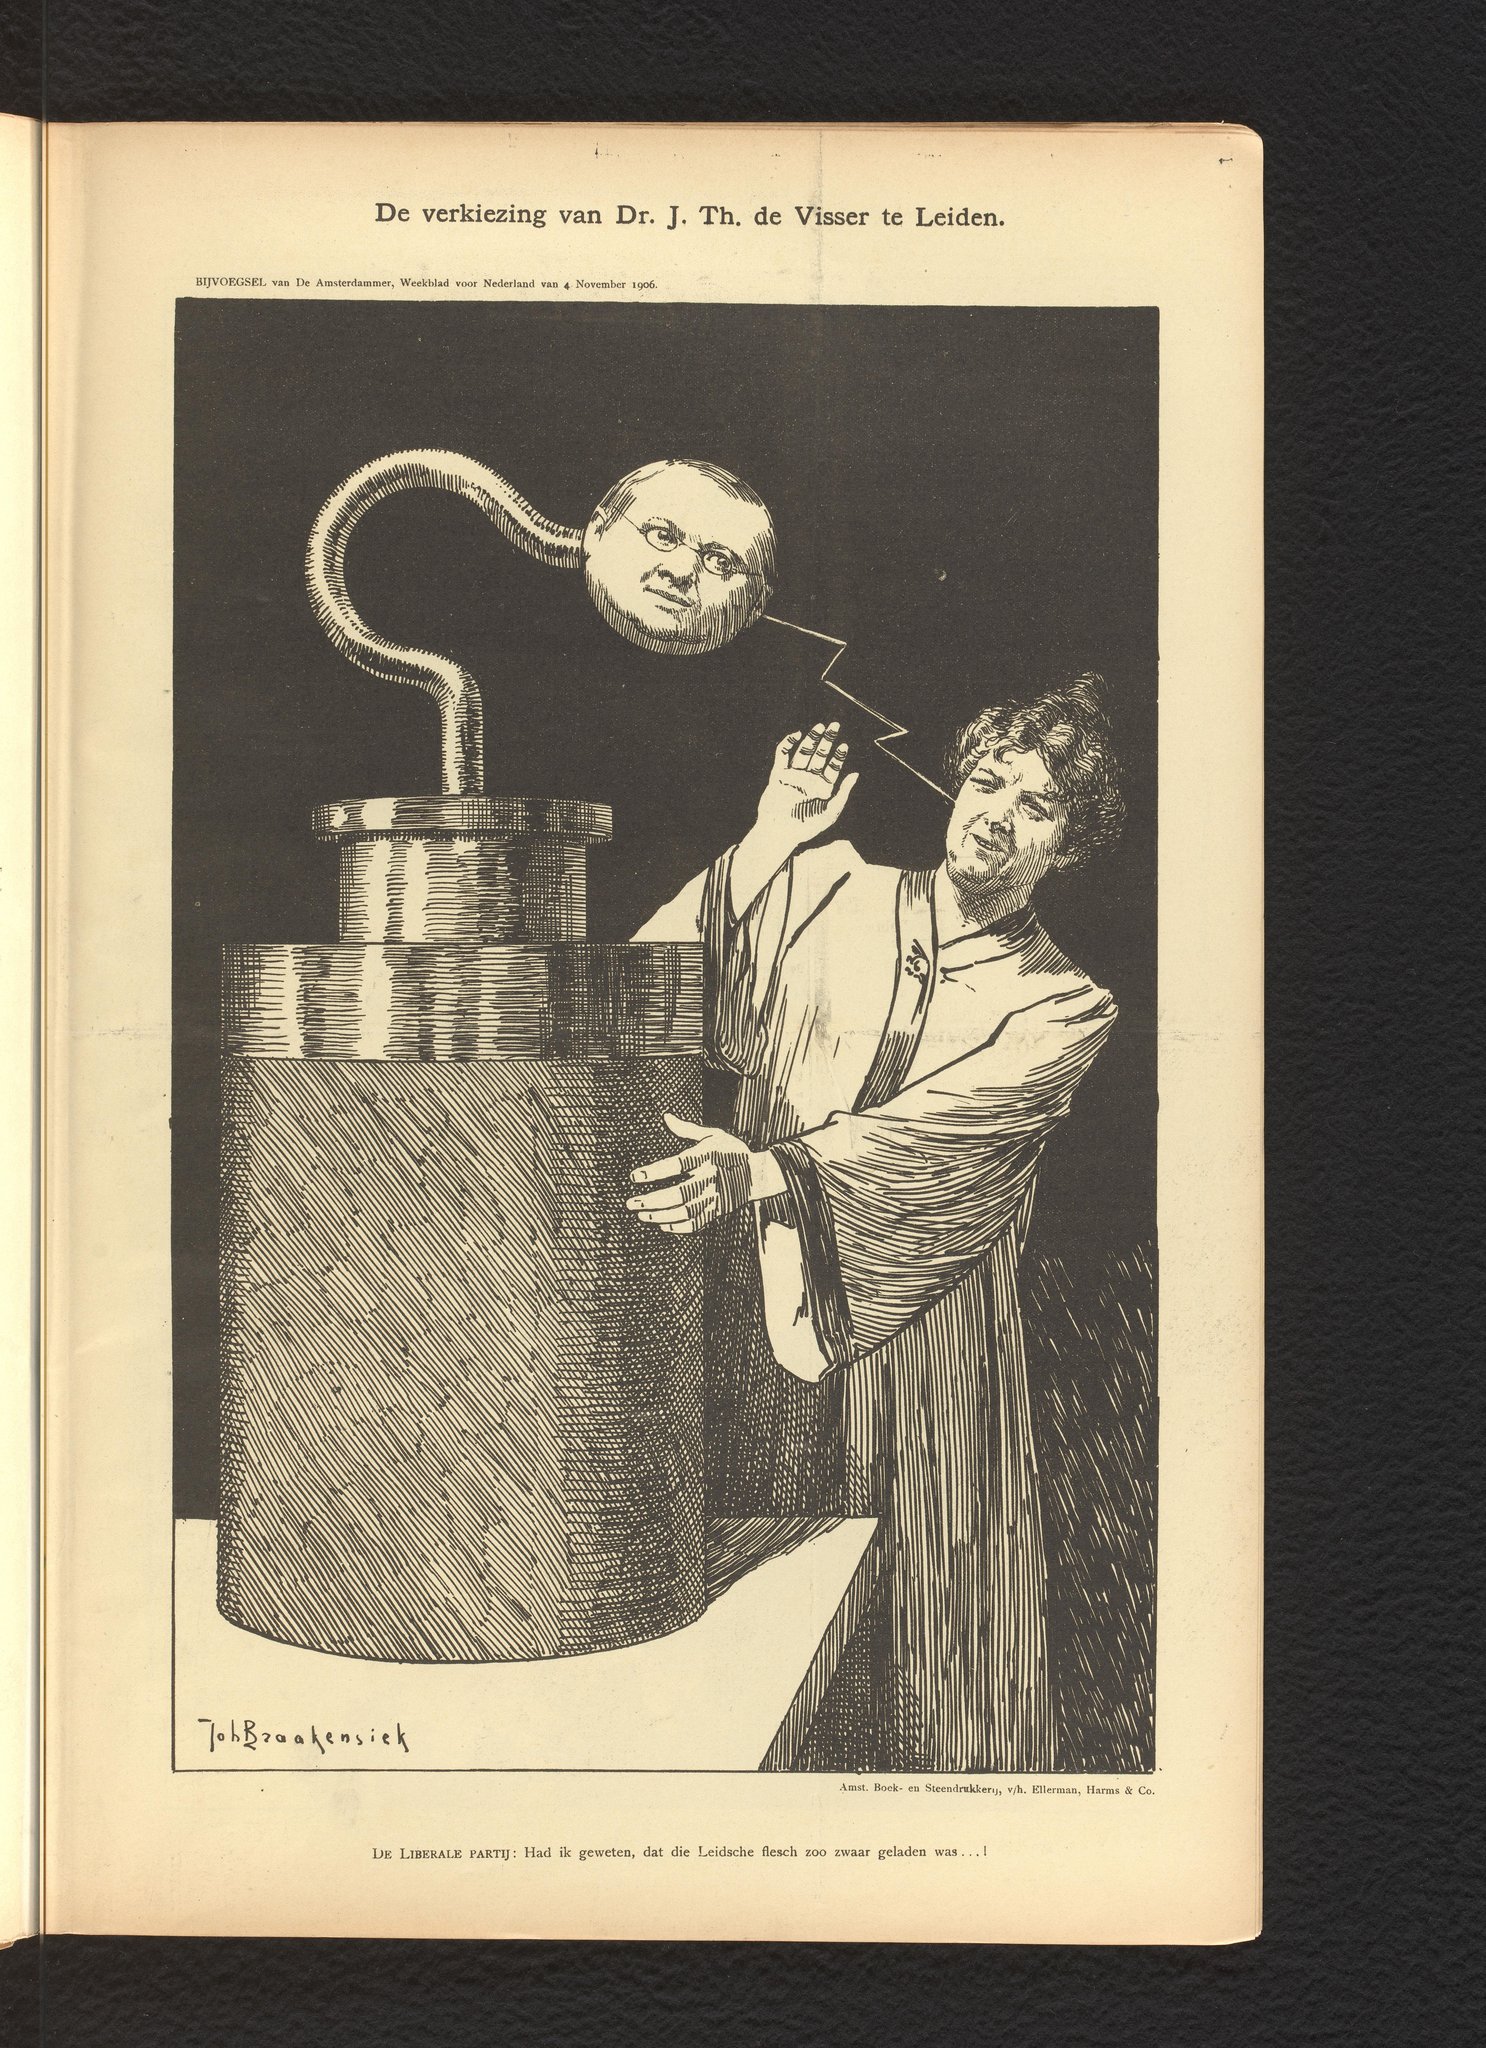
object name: cartoon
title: De verkiezing van Dr. J. Th. de Visser te Leiden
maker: johan braakensiek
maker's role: draughtsman, print maker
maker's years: 1858-1940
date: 1906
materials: paper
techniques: lithograph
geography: netherlands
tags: utrecht, the hague, spark ~ electricity, political parties, political caricatures and satires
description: De vrouwelijke personificatie van de Liberale Partij (Liberale Unie) krijgt een elektrische schok uit een zogenaamde 'Leidse fles' als blijkt dat Johannes Theodoor de Visser als kamerlid voor het kiesdistrict Leiden gekozen wordt.